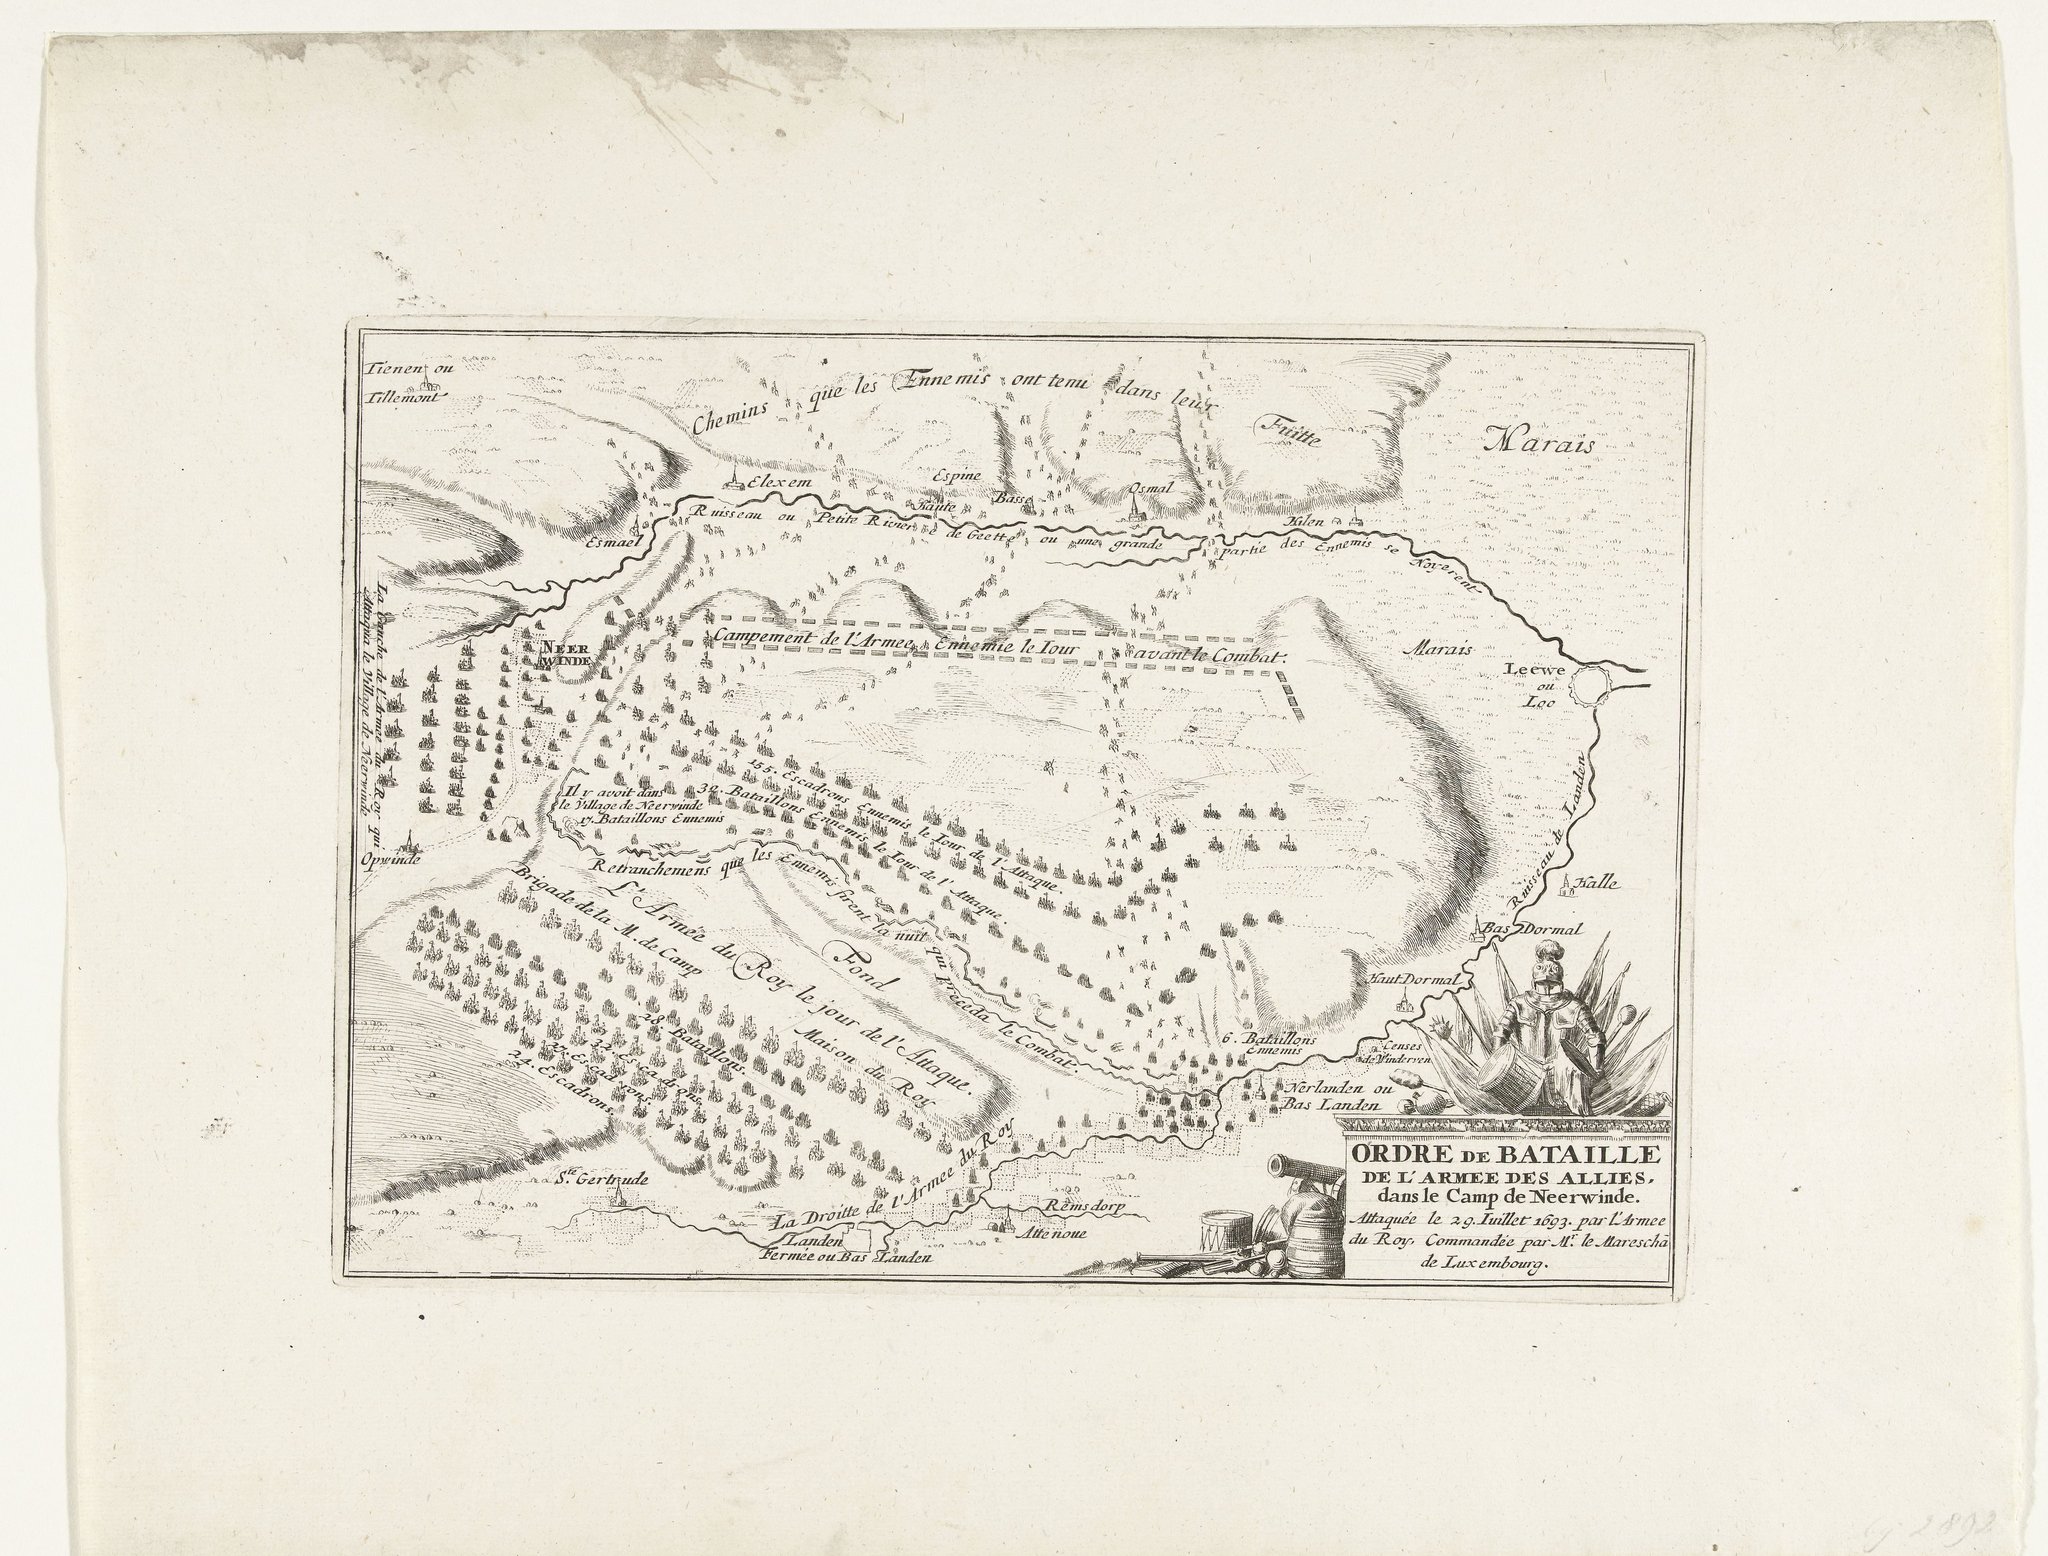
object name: print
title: Kaart van de slag bij Landen, 1693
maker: Anonymous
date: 1693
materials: paper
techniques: etching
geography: france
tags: william iii (prince of orange and king of england, scotland, and ireland), paris, maps of separate countries or regions, battle (+ land forces)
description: Kaart van de veldslag bij Landen (Neerwinden) tussen de geallieerden onder koning Willem III en de Fransen onder de hertog van Luxemburg, 29 juli 1693. Rechtsonder een cartouche met de Franse titel en wapentrofeeën.